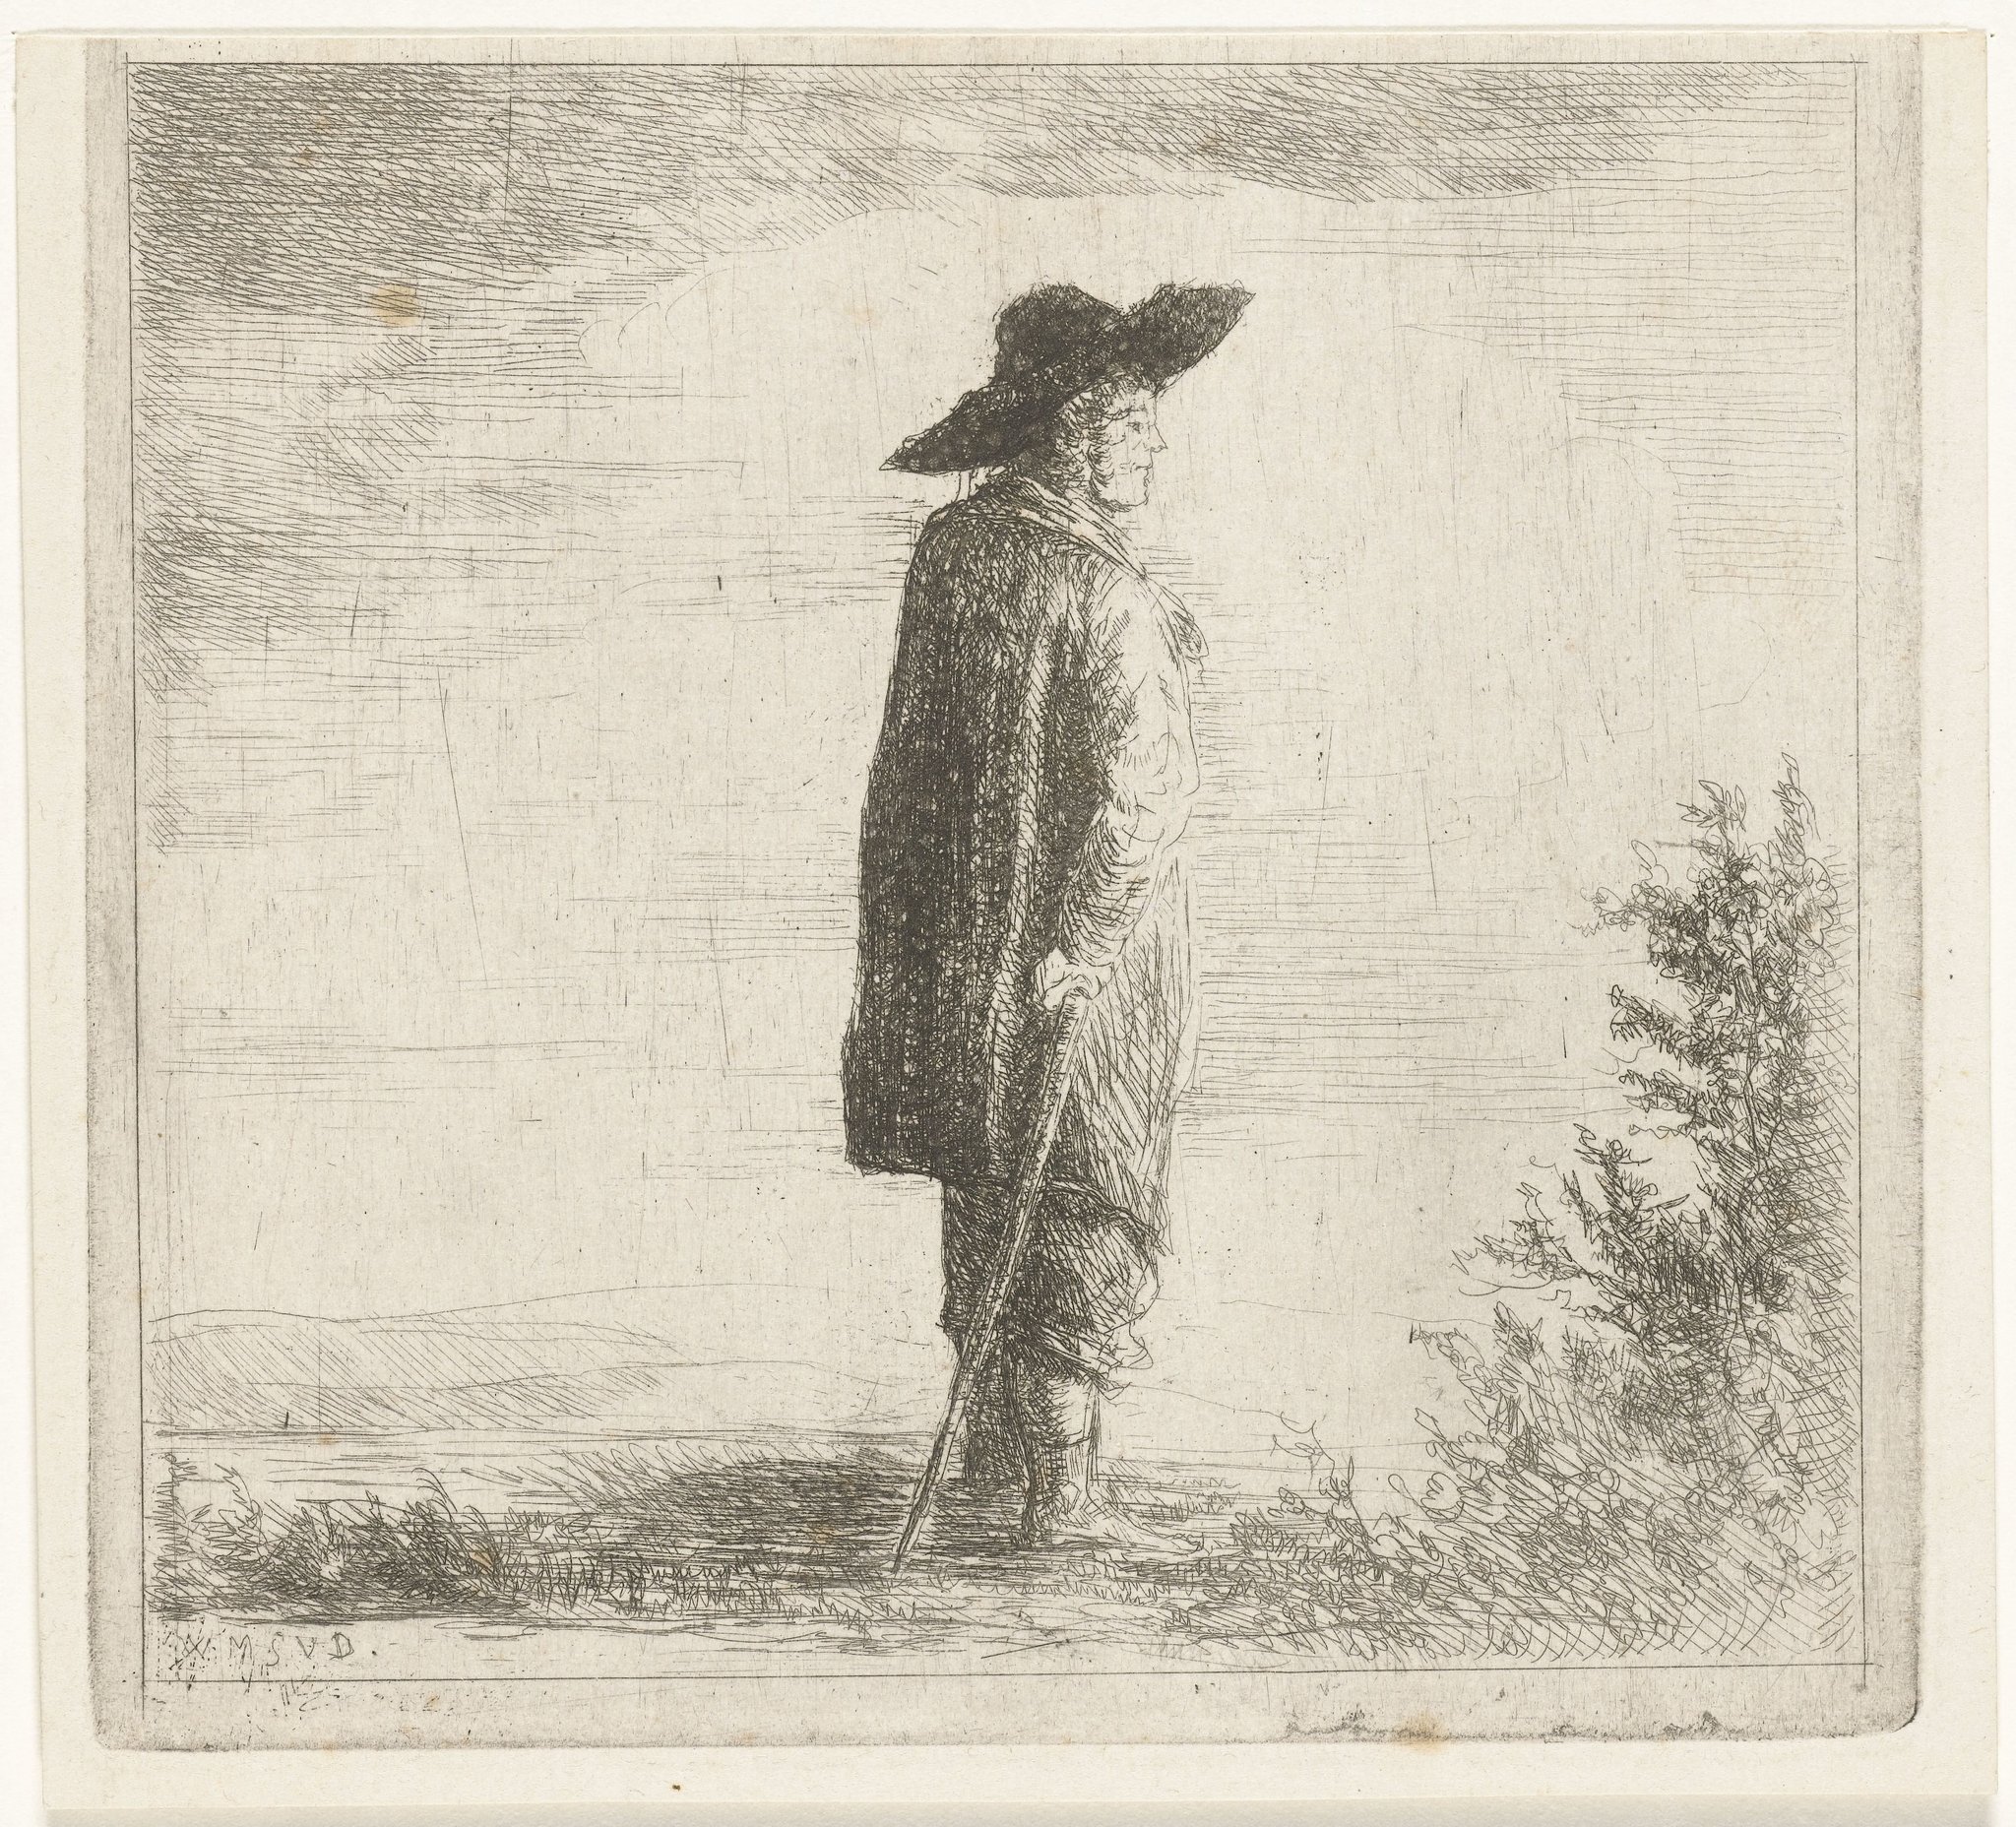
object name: print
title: Man met hoed en stok in landschap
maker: willem matthias jan van dielen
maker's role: print maker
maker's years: 1805-1867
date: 1815-1867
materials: paper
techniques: etching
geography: netherlands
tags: low hill country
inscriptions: collector's mark: Lugt 2228, collector's mark: Lugt 1485